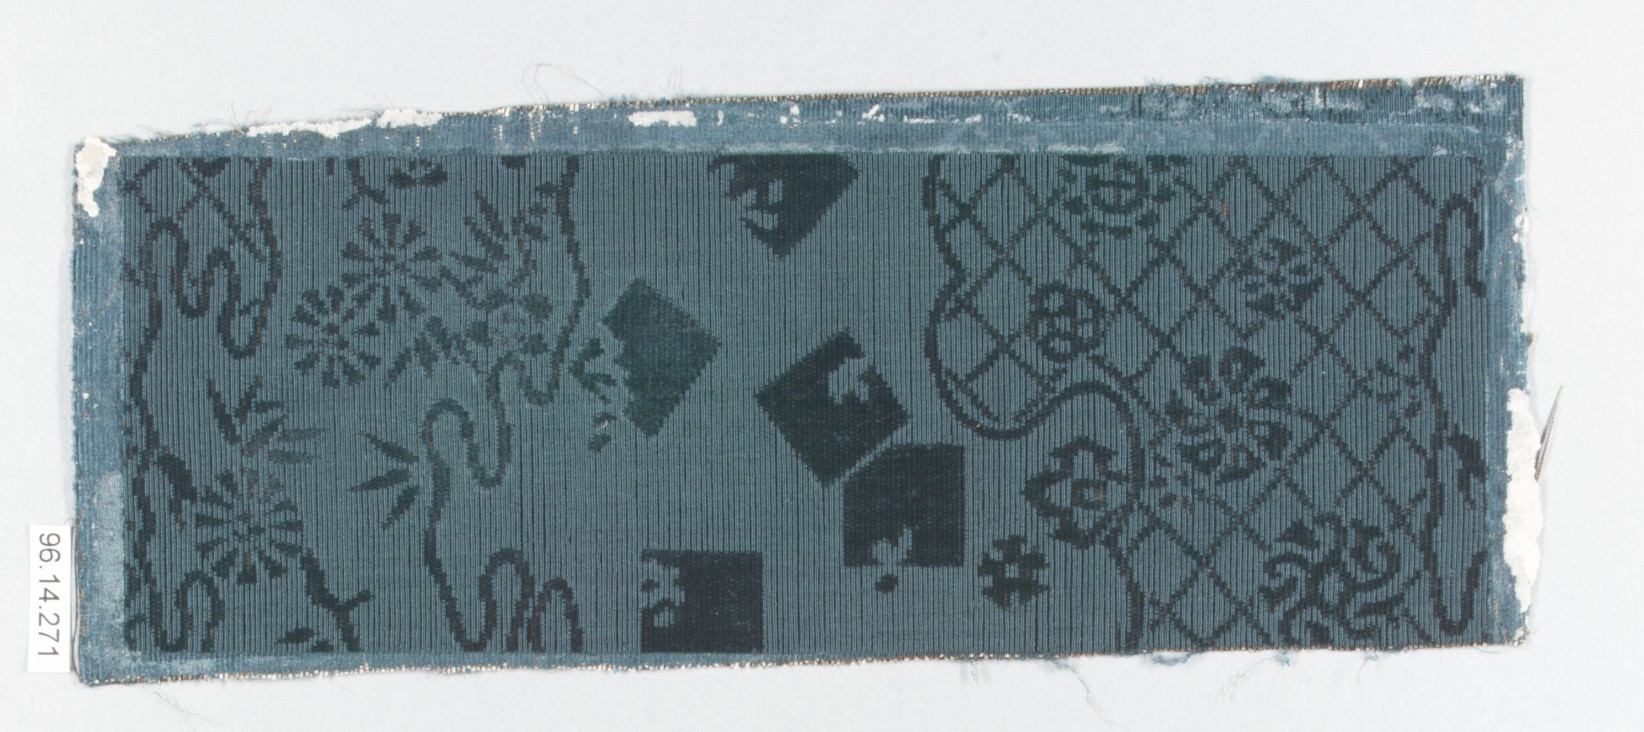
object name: piece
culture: japanese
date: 1701-1900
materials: silk